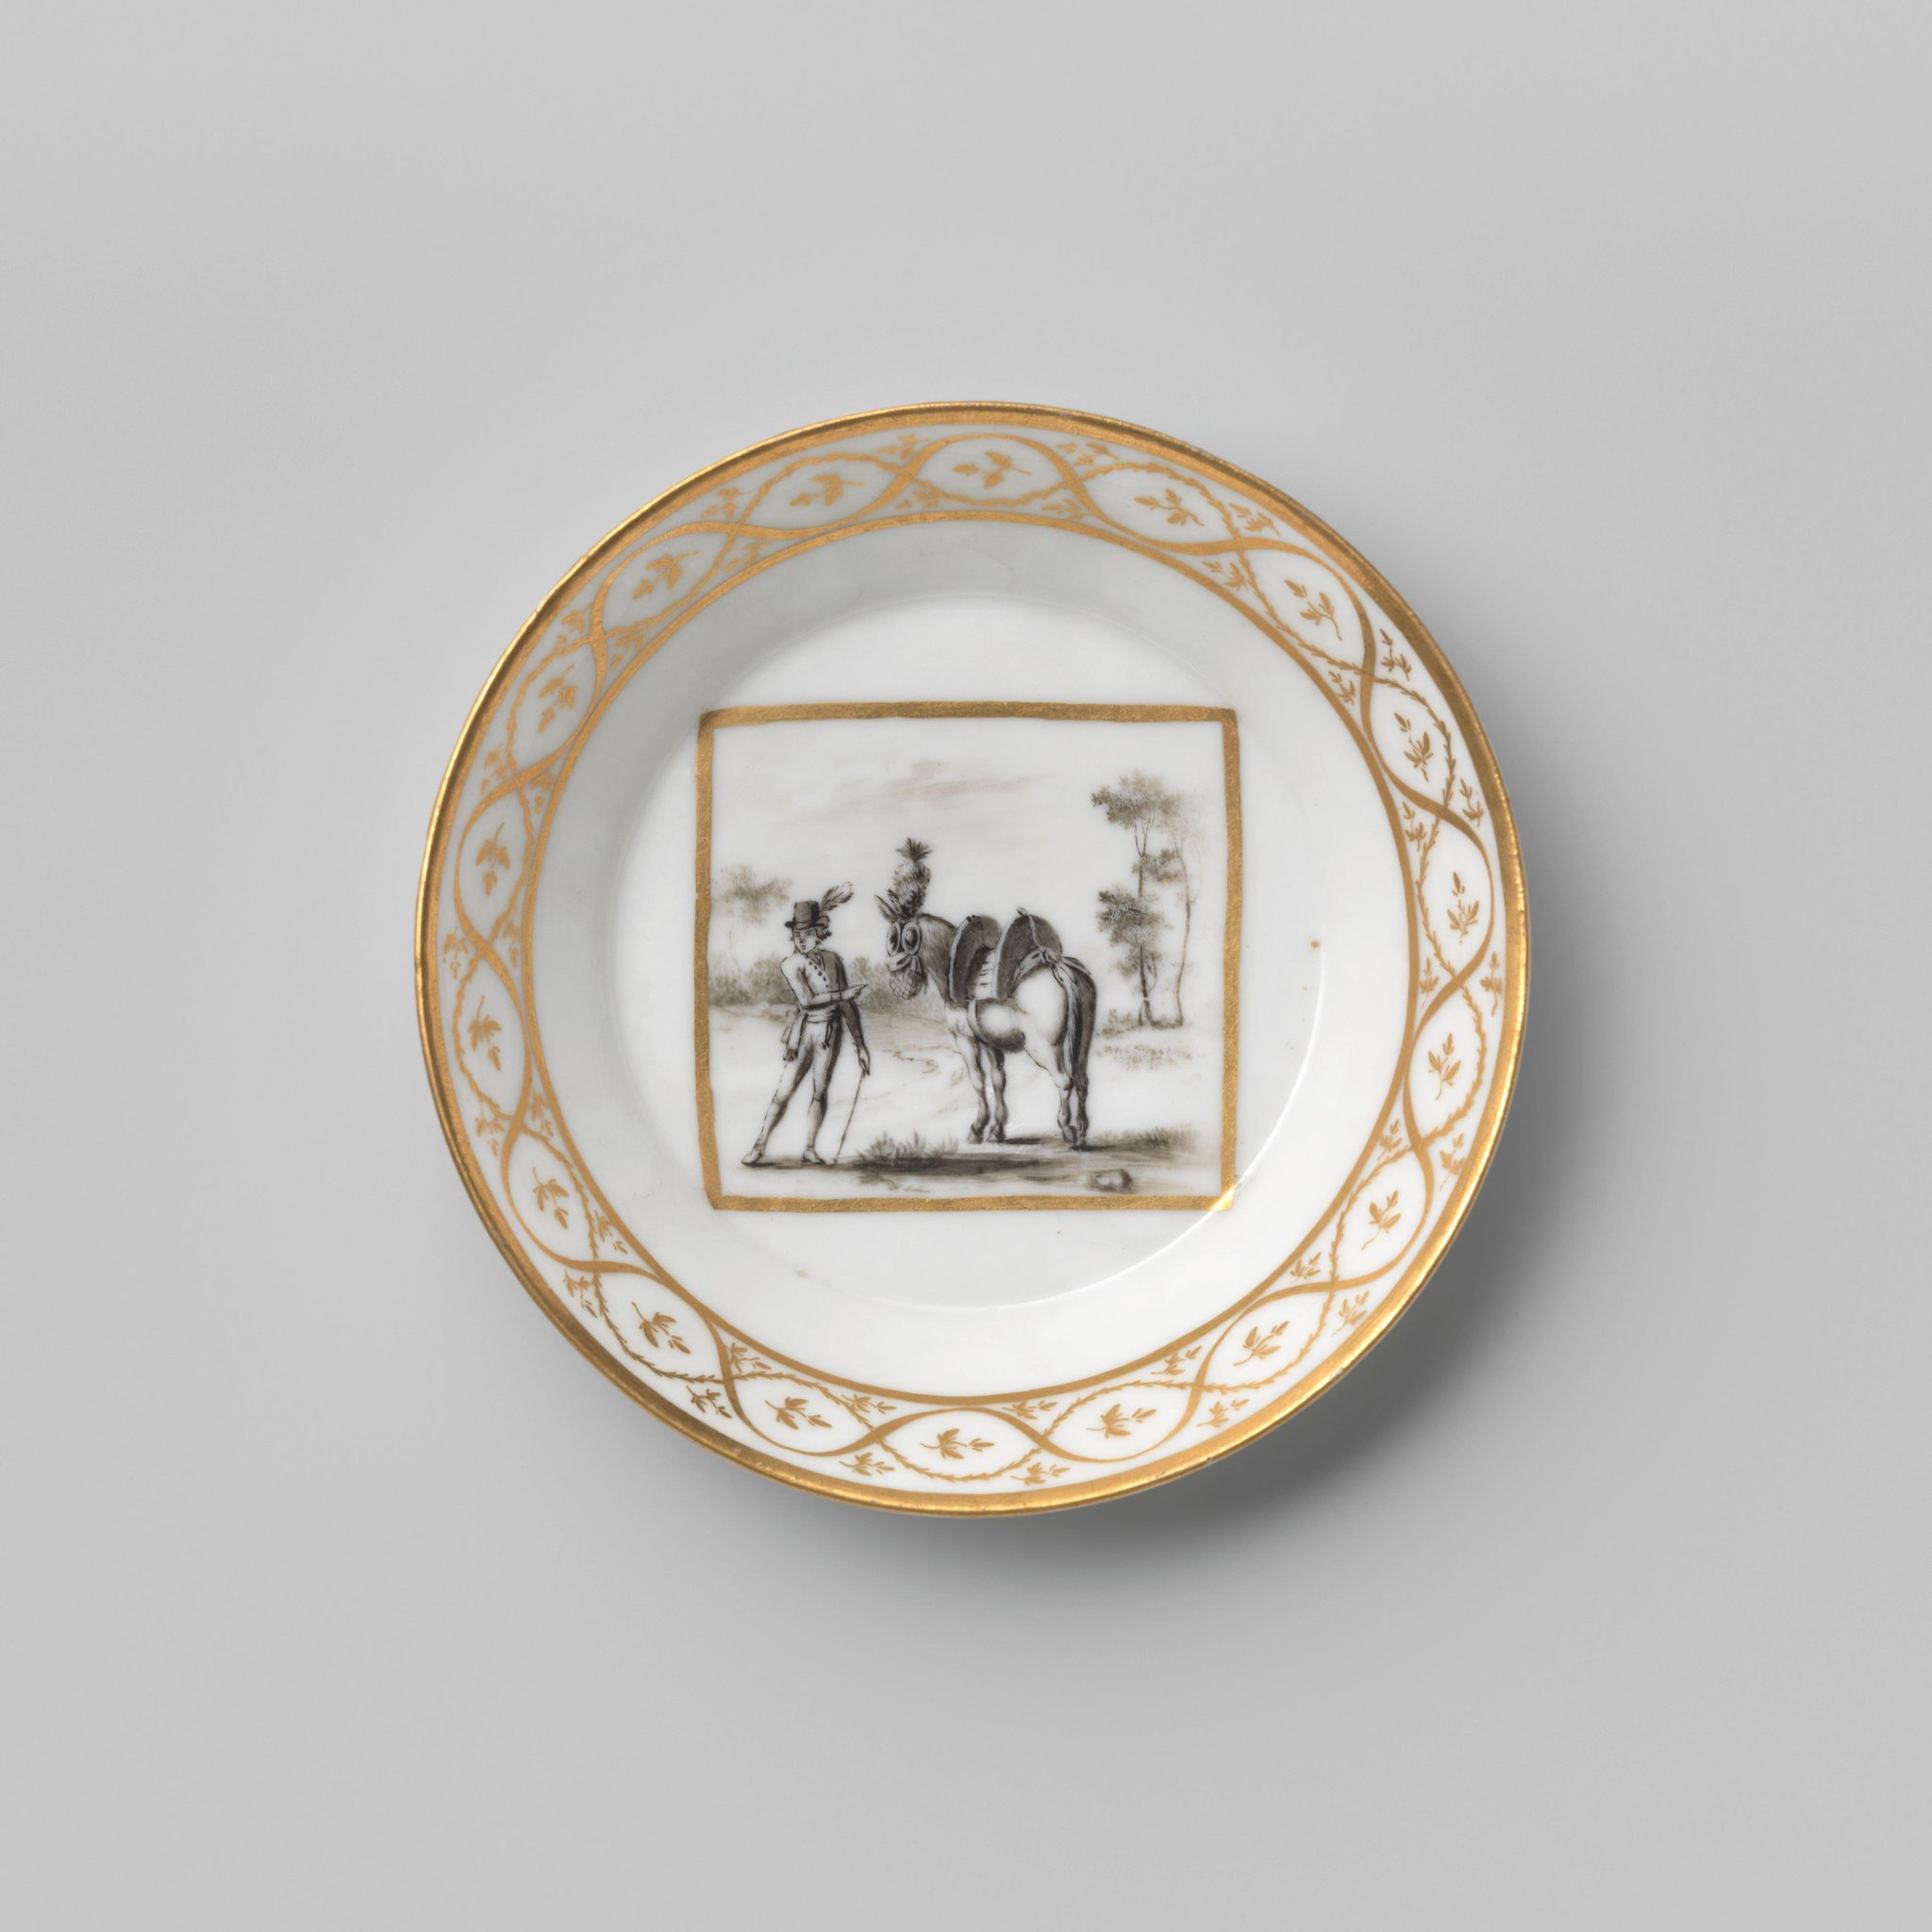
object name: platter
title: Saucer with a man and mule in a landscape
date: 1775-1799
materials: glaze, gold, paint, porcelain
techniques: firing, forming, gilding, turning, vitrification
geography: paris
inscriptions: mark: ‘Potter 3’, mark: ‘S’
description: Schotel van porselein met een rechte wand, beschilderd op het glazuur in zwart en goud. Op het plat een vak met een man met een muilezel in een landschap. Op de binnenwand een band met een bladrank en losse takken. Gemerkt op de onderzijde met Potter 3 en S.